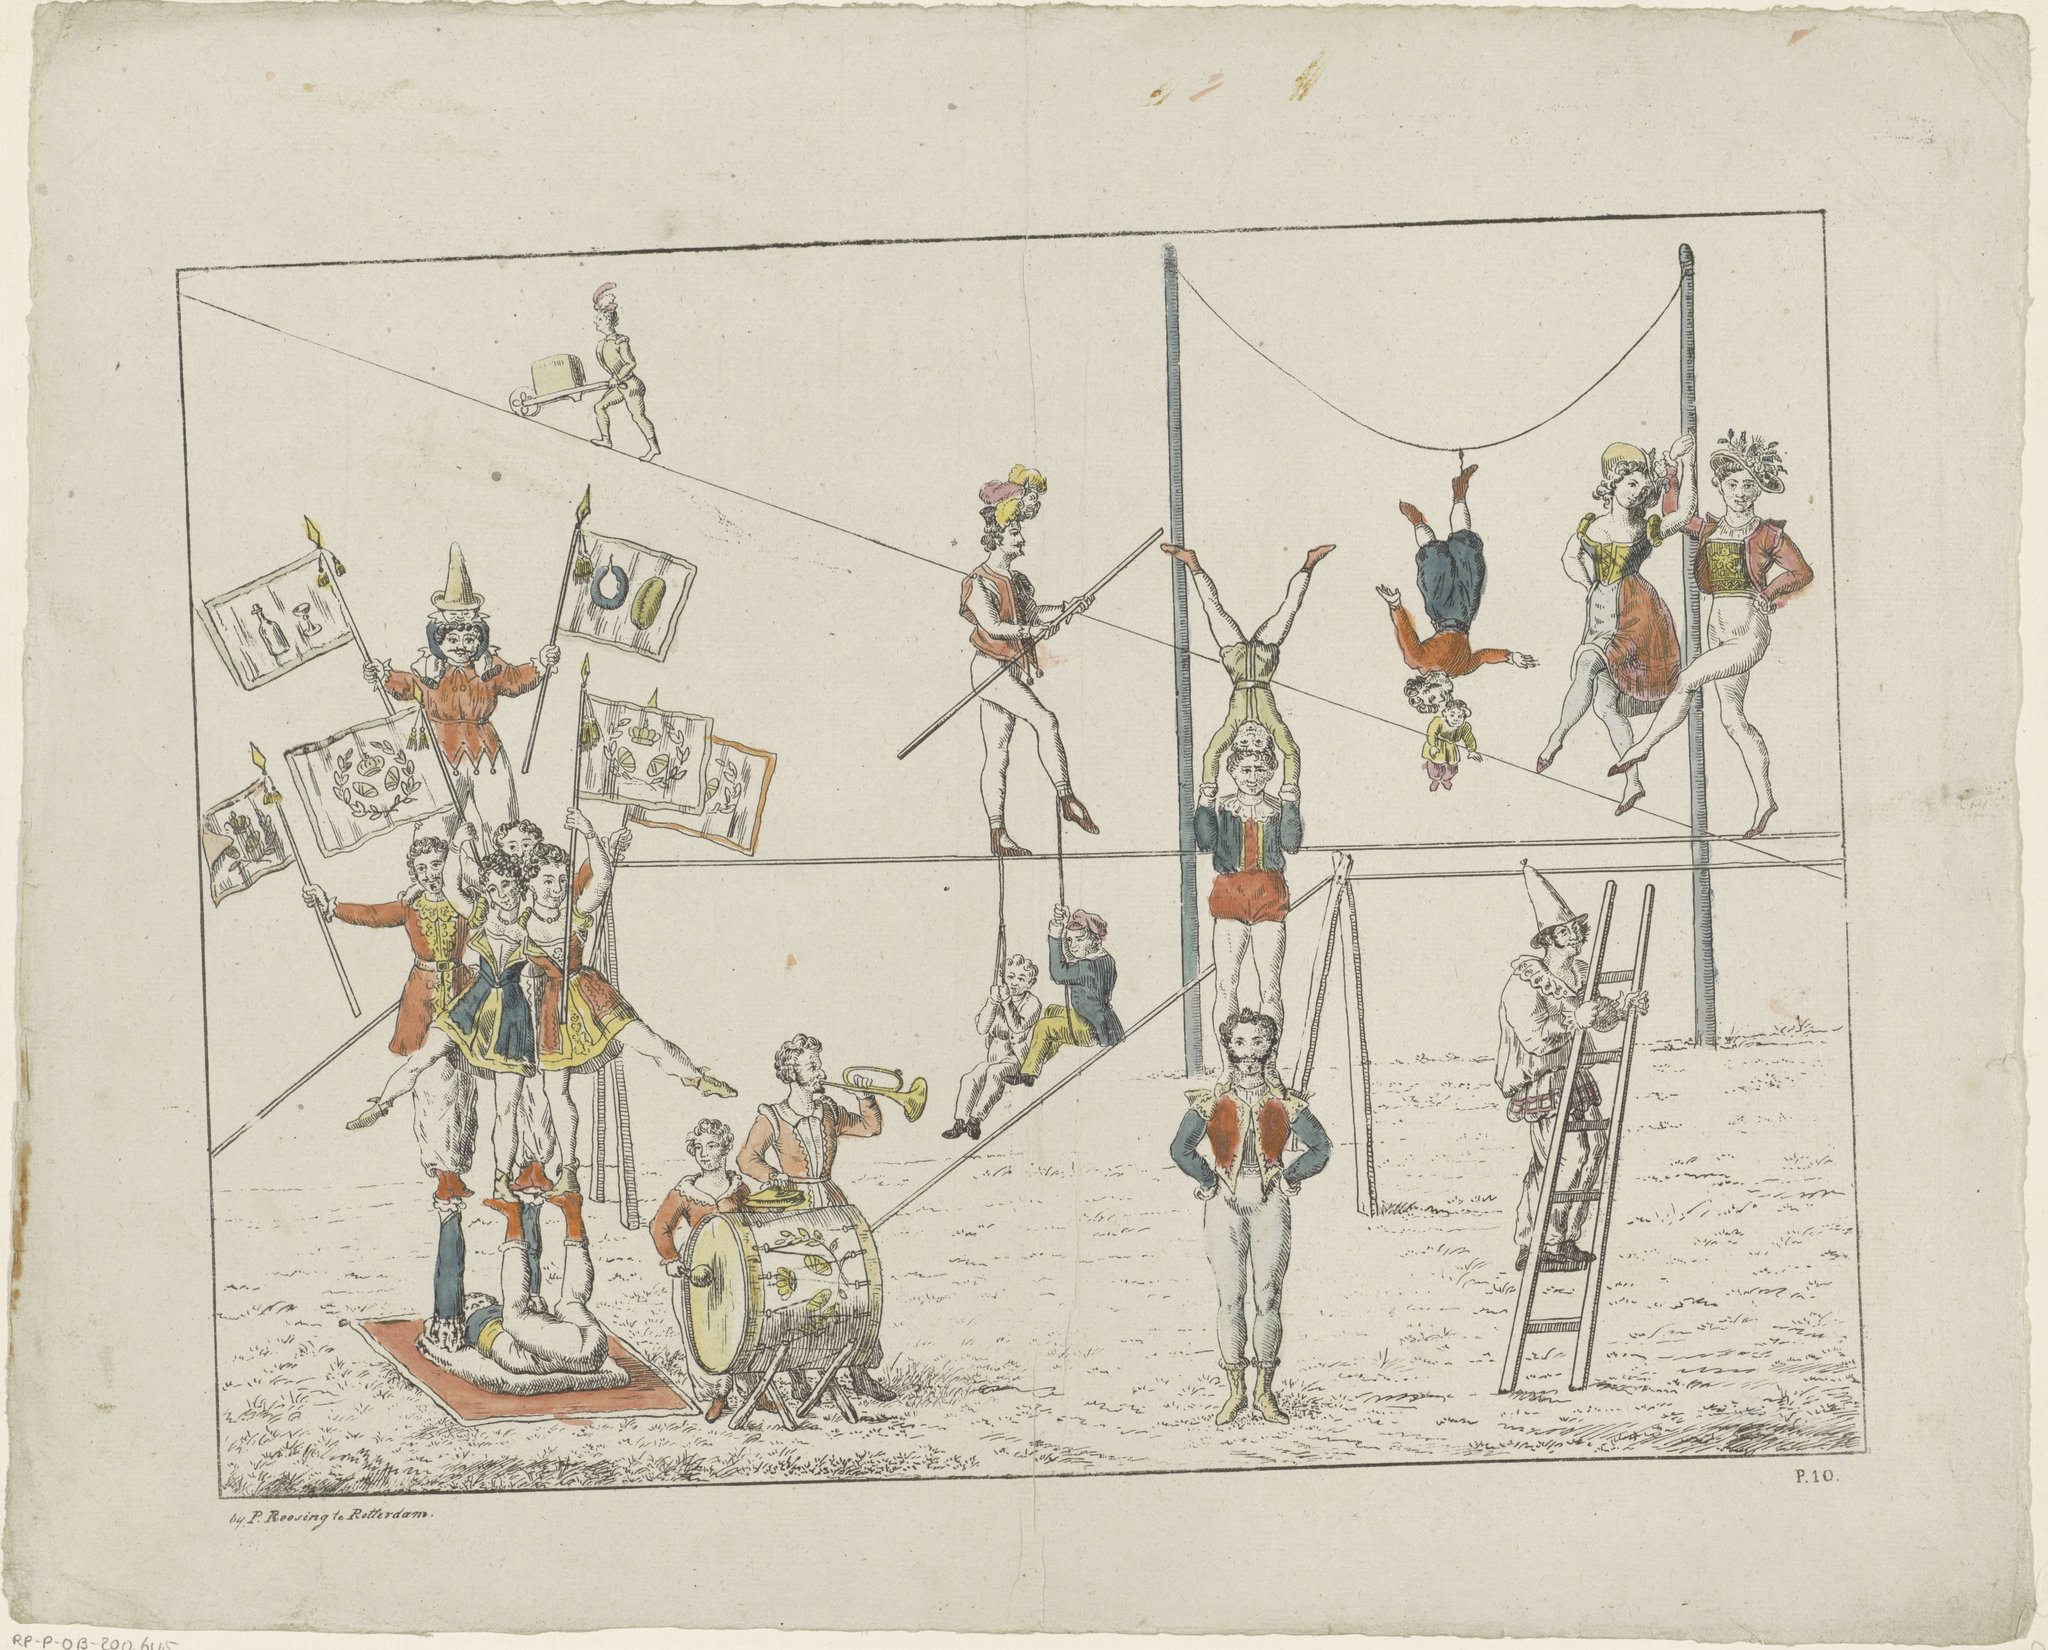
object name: popular print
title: Circustafereel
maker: pieter roosing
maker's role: print maker, publisher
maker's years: 1794-1839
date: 1814-1839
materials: paper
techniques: hand coloring, lithograph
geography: rotterdam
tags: musician, acrobat ~ circus, circus, tight-ropewalker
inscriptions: collector's mark: Lugt 2760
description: Een circustafereel met acrobaten, muzikanten en koorddansers. Genummerd rechtsonder: P. 10.